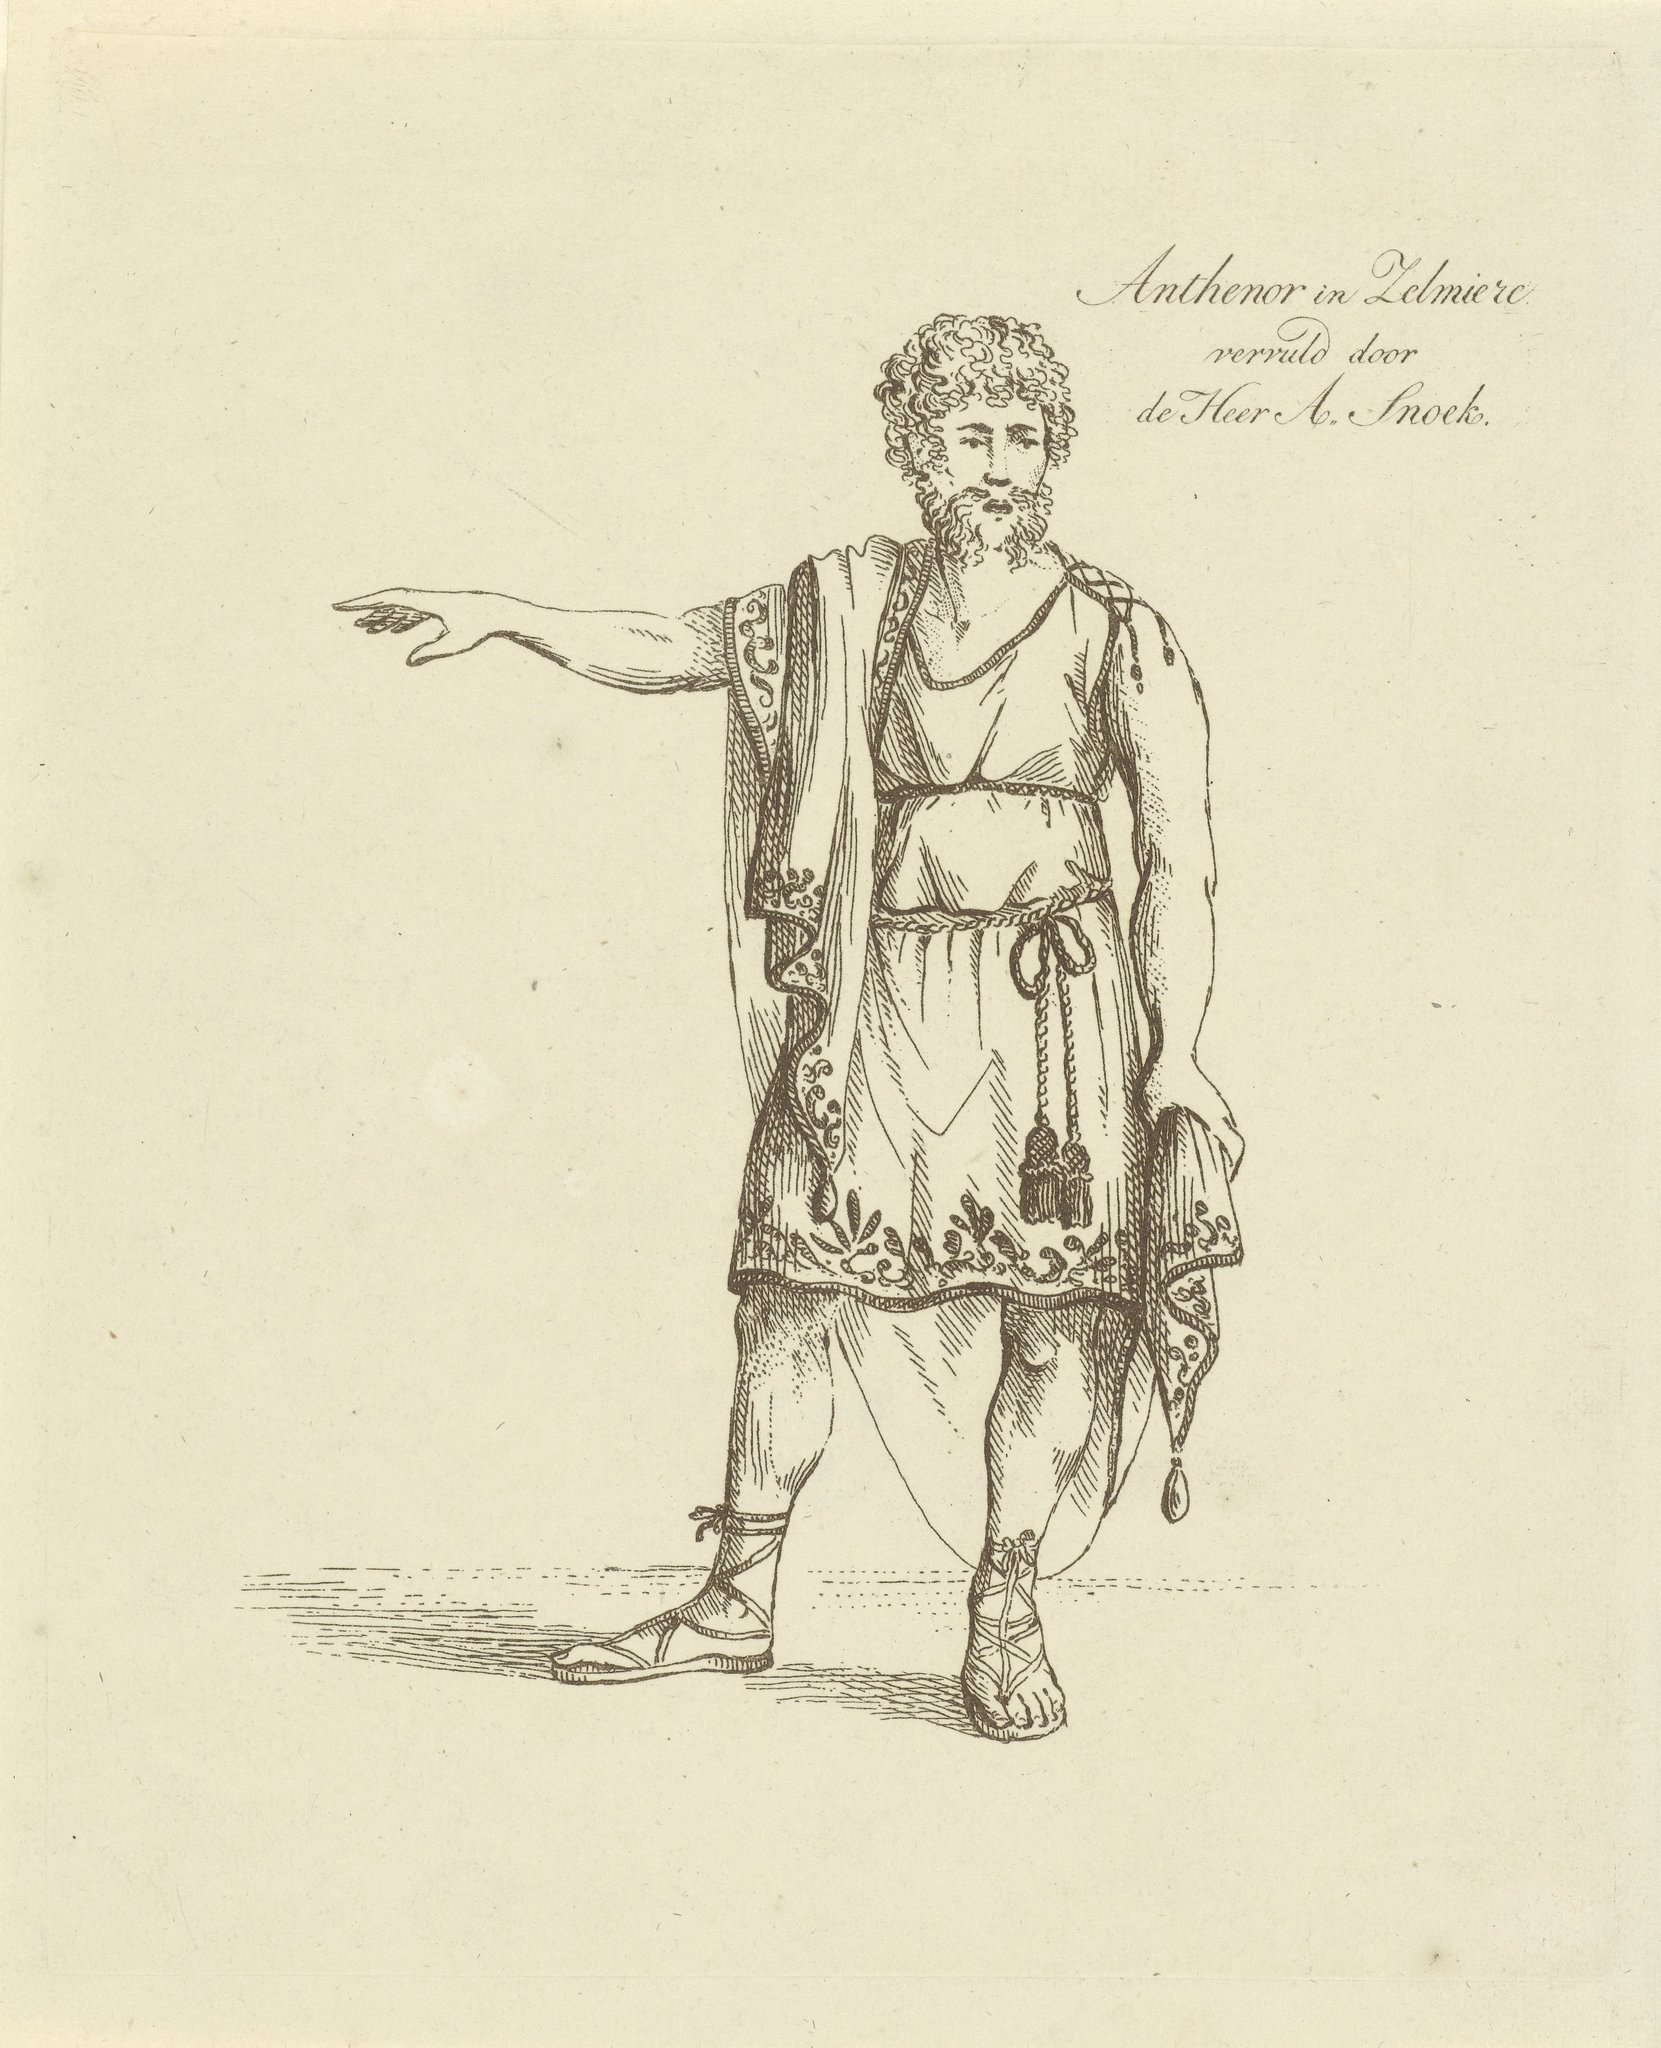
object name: print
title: Acteurs en actrices in verschillende rollen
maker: johannes jelgerhuis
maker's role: draughtsman, painter, print maker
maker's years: 1770-1836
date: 1805-1836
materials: paper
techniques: etching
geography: amsterdam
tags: rotterdam, actor (on the stage), historical persons (portraits and scenes from the life) (+ all kinds of 'portrait historié': mythological portrait, allegorical portrait, 'rollenporträt', etc.)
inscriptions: collector's mark: Lugt 2228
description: De acteur Andreas Snoek als Anthenor, gekleed in Romeinse toga, wijzend. Prent uit een serie van tien met Nederlandse acteurs en actrices in verschillende rollen.